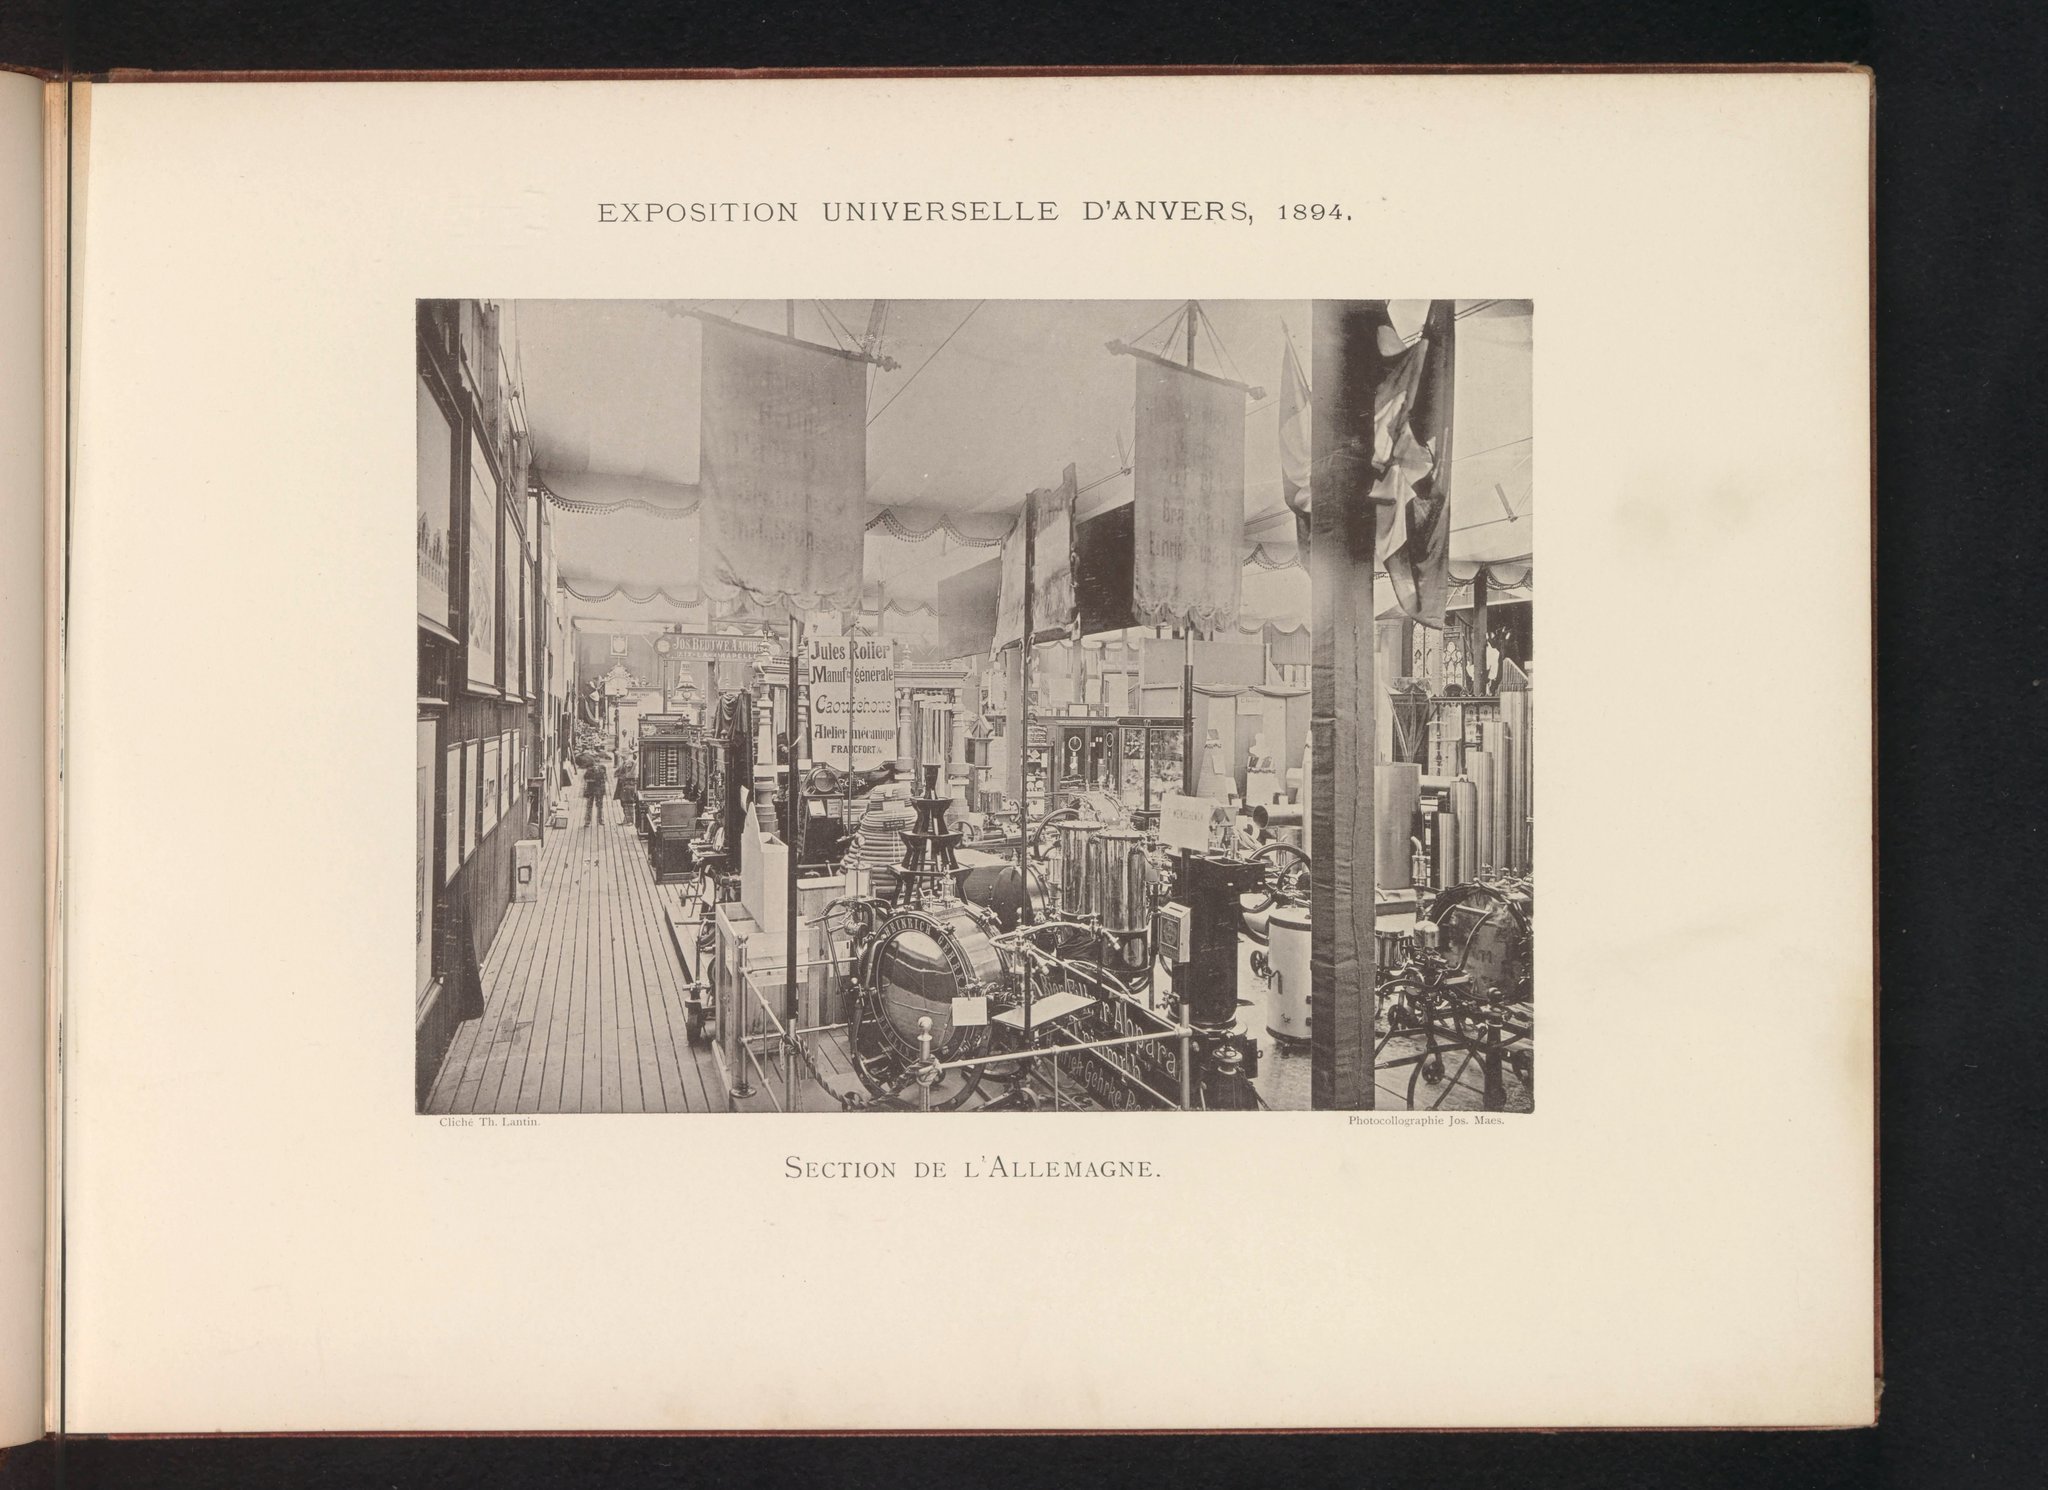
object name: page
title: Section de l'Allemagne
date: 1894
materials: paper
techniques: photograph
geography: antwerp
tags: world fair, world exhibition, collection, exhibition, show